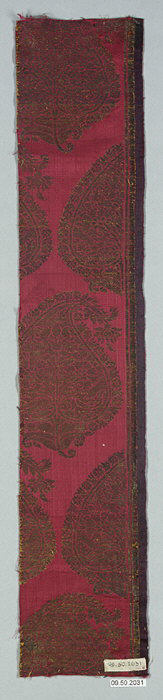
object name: textile fragment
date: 1801-1900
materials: metal thread, silk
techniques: brocade, weave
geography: india